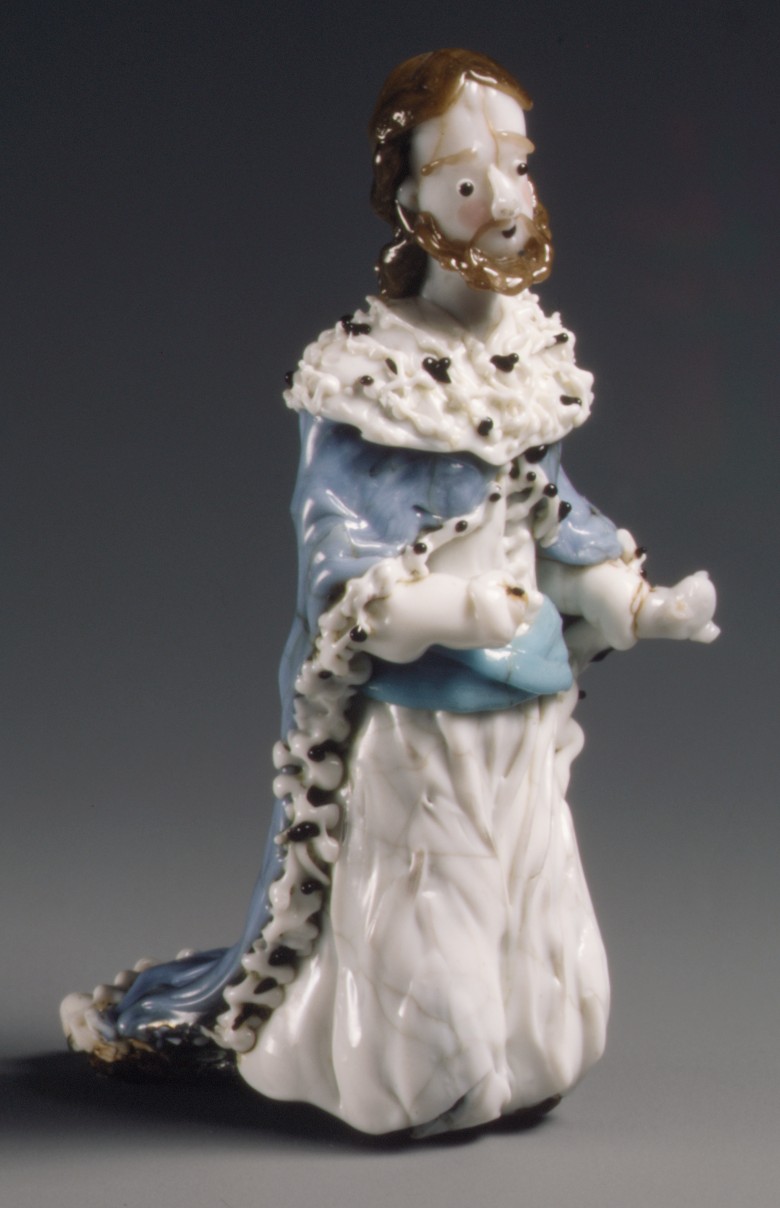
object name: statuette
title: King from a Nativity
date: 1701-1800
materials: glass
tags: kings,nativity